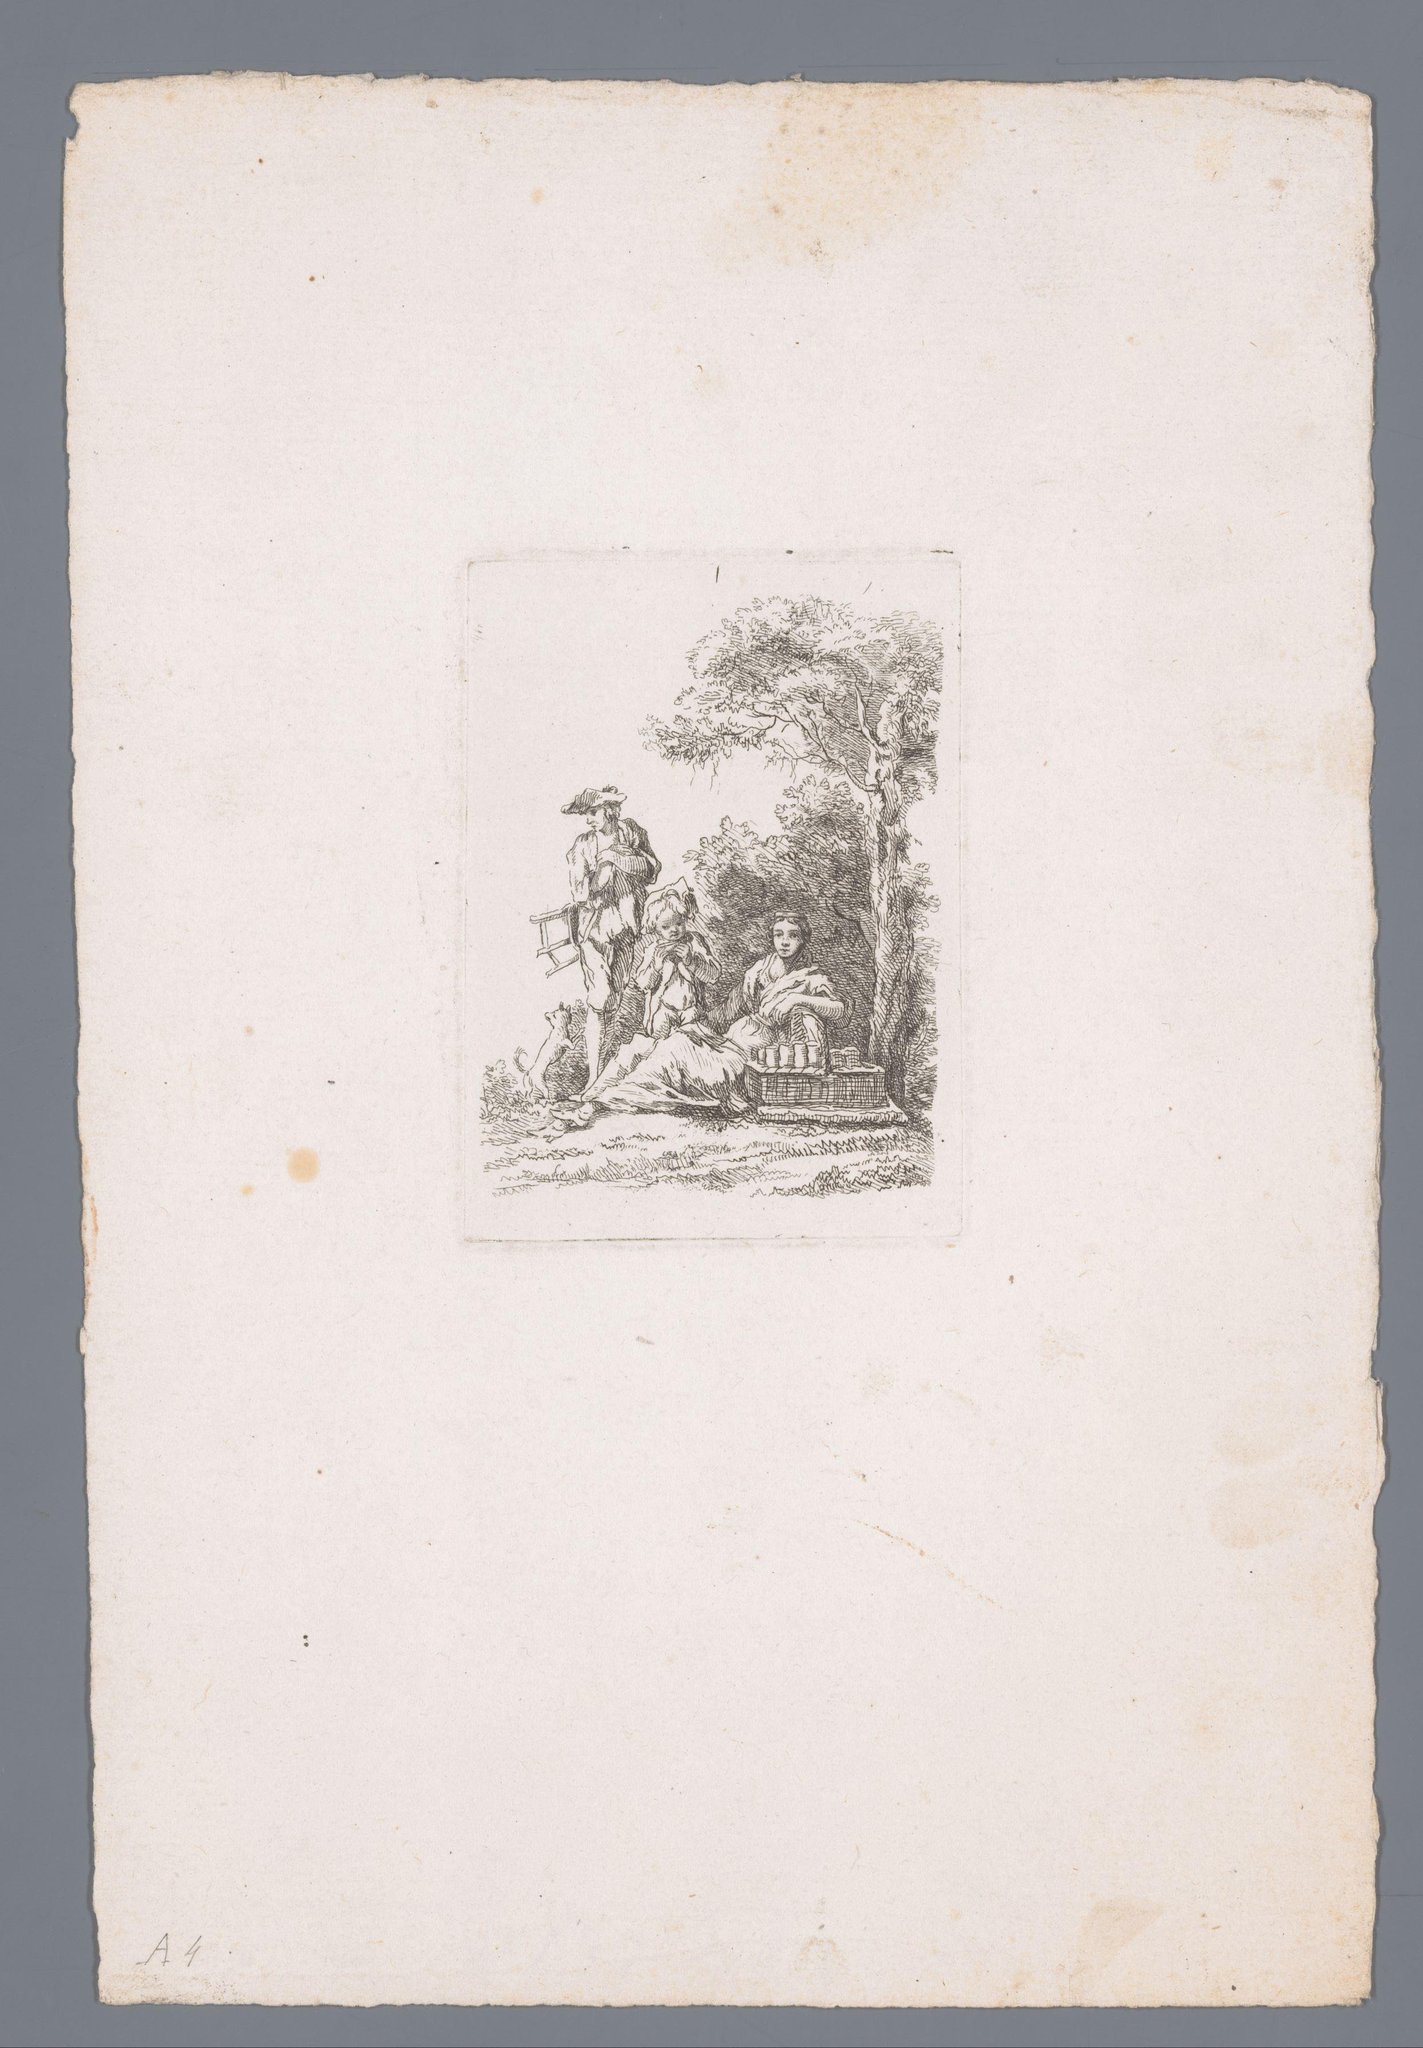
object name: print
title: Picknick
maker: Anonymous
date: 1700-1799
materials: paper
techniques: etching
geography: germany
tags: trees, picnic, alfresco, 'déjeuner sur l'herbe'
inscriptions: : ‘Geschenk van J.H. Coster’